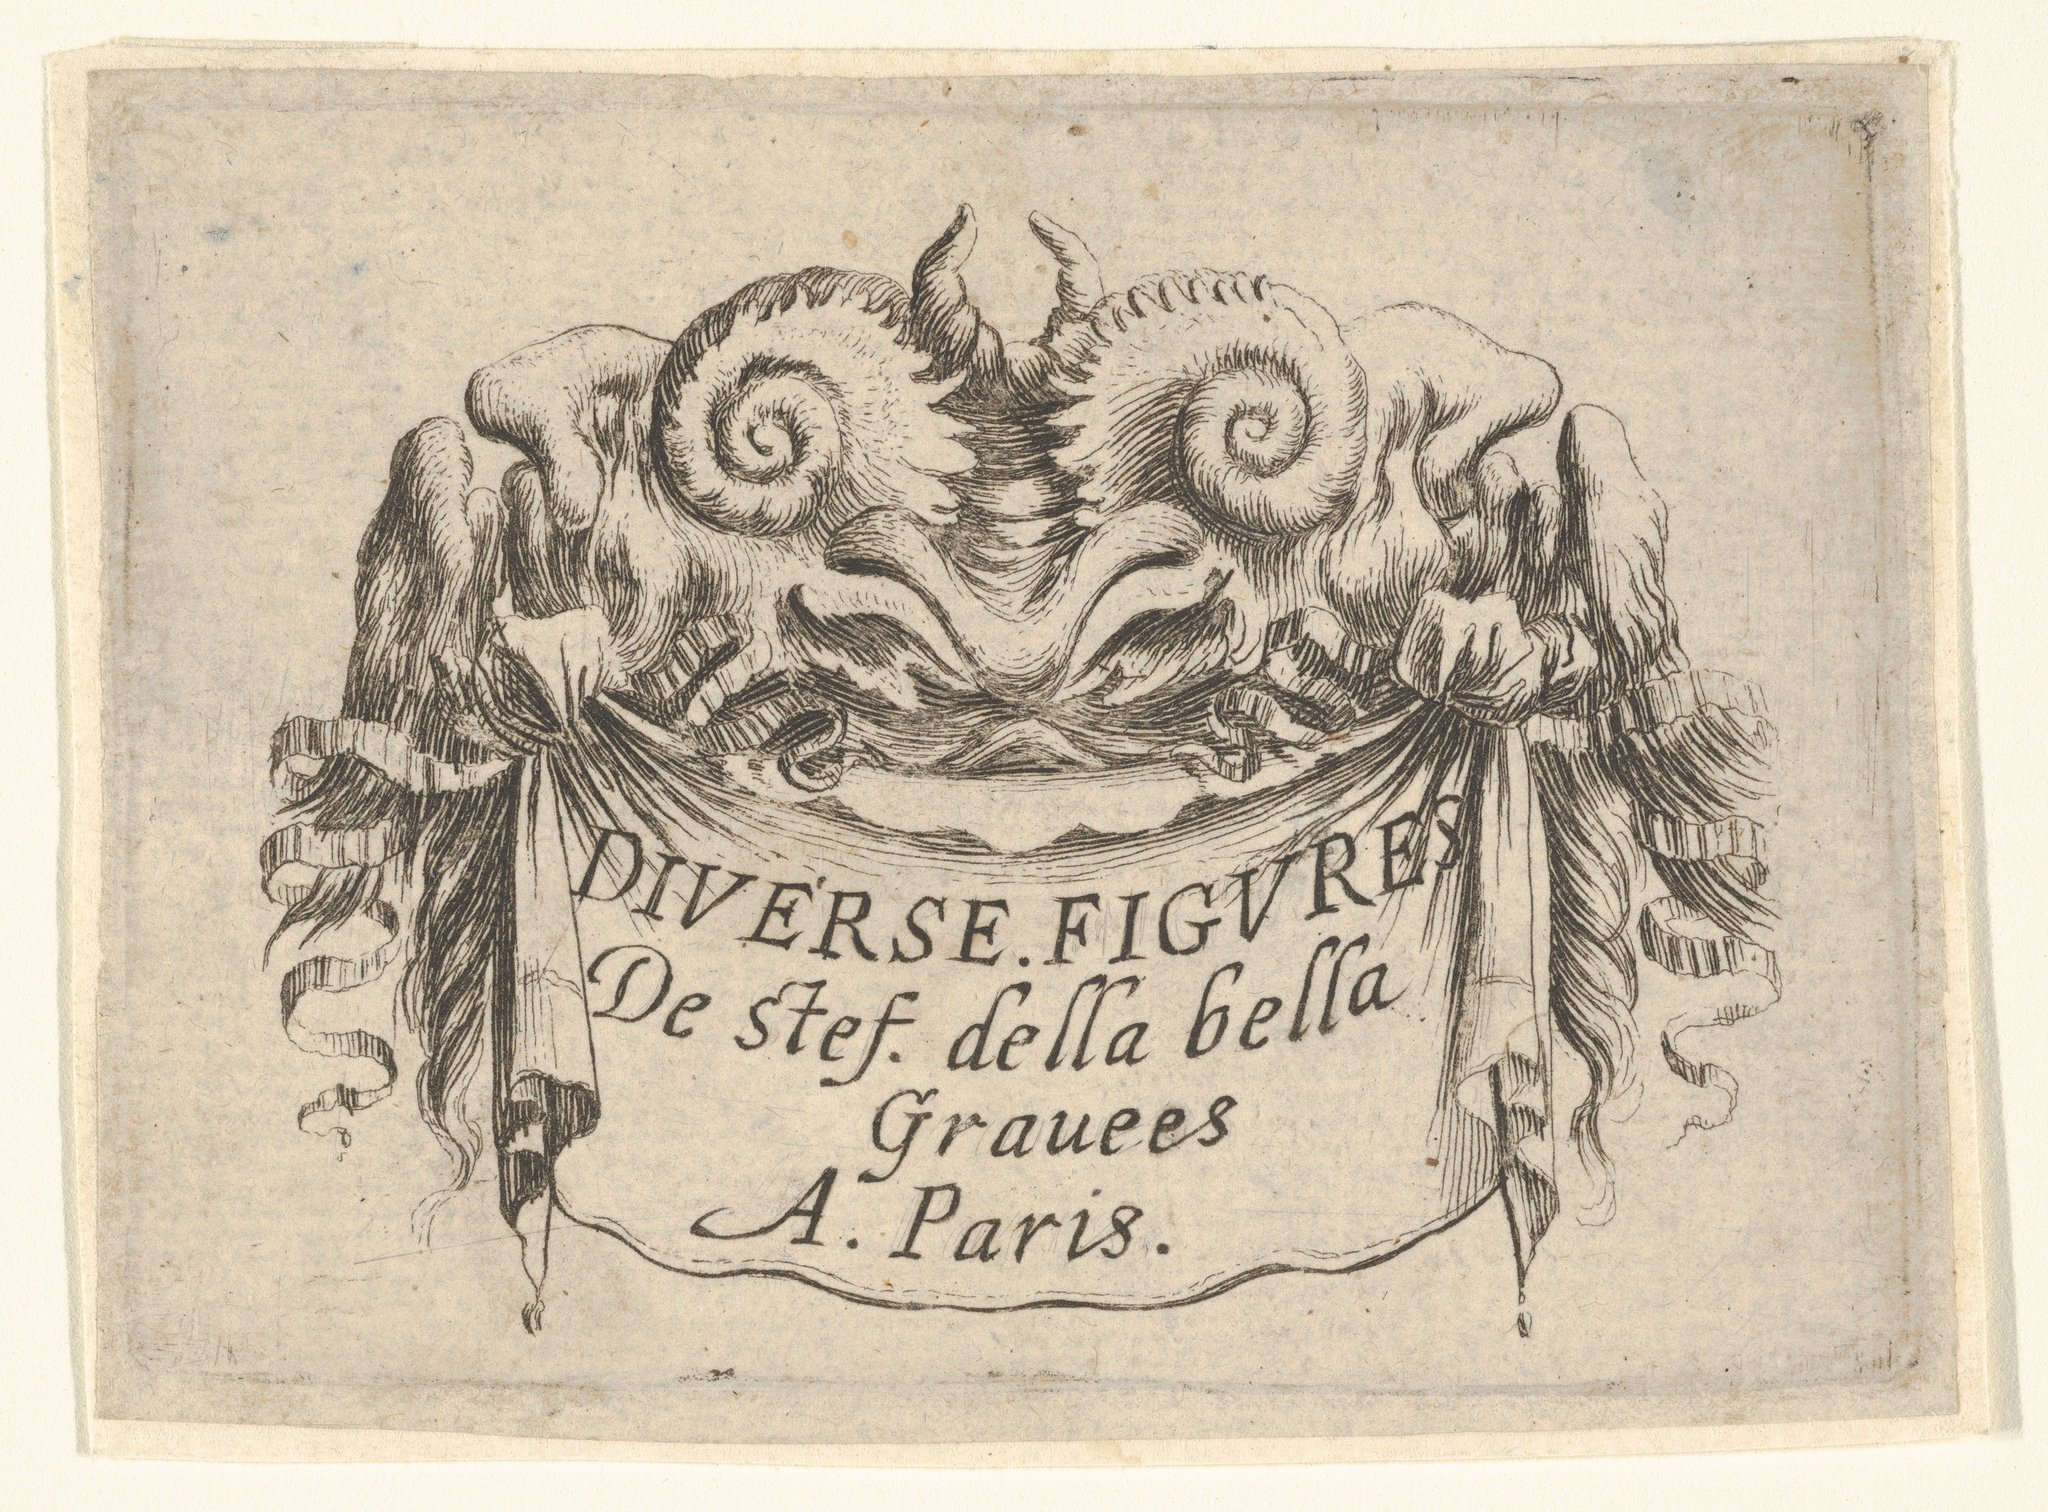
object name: print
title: Title Plate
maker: françois chauveau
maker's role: artist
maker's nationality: french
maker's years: 1613-1676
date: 1601-1700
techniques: etching